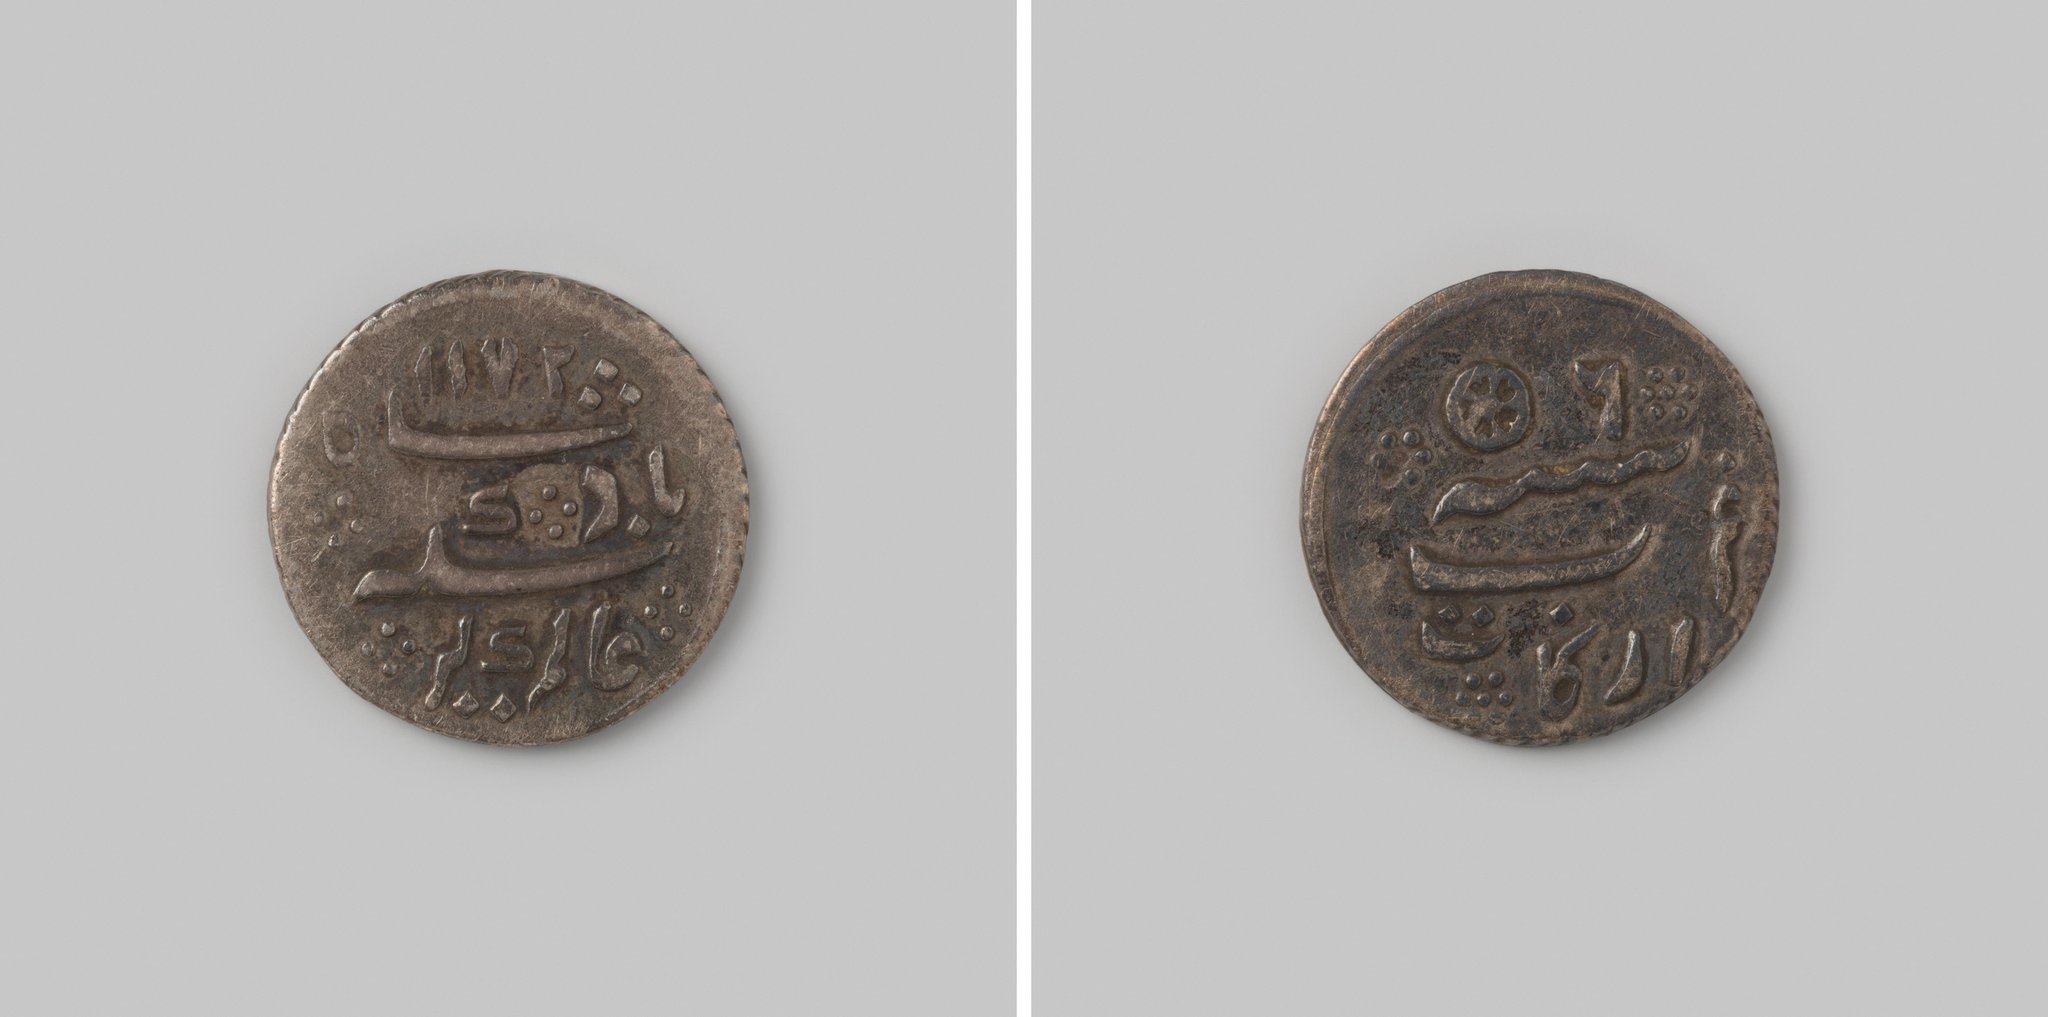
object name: coin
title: 1/8 Arkot-roepie voor Madras in India van de Engelse Oostindische Compagnie (EIC) op naam van sjah Alamgir II,1172 [=1759]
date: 1823-1825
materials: silver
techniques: striking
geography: kolkata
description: Zilveren munt. Voorzijde: in Arabische lettertekens in drie regels opschrift met bovenaan aanduiding jaartal: 1172. Keerzijde: in Arabische lettertekens in twee regels opschrift. Bovenaan regeringsjaaar: 6 met links daarvan rozet [=muntplaats Calcutta]. Geslagen in de jaren 1823-1825 te Calcutta. Kabelrand.